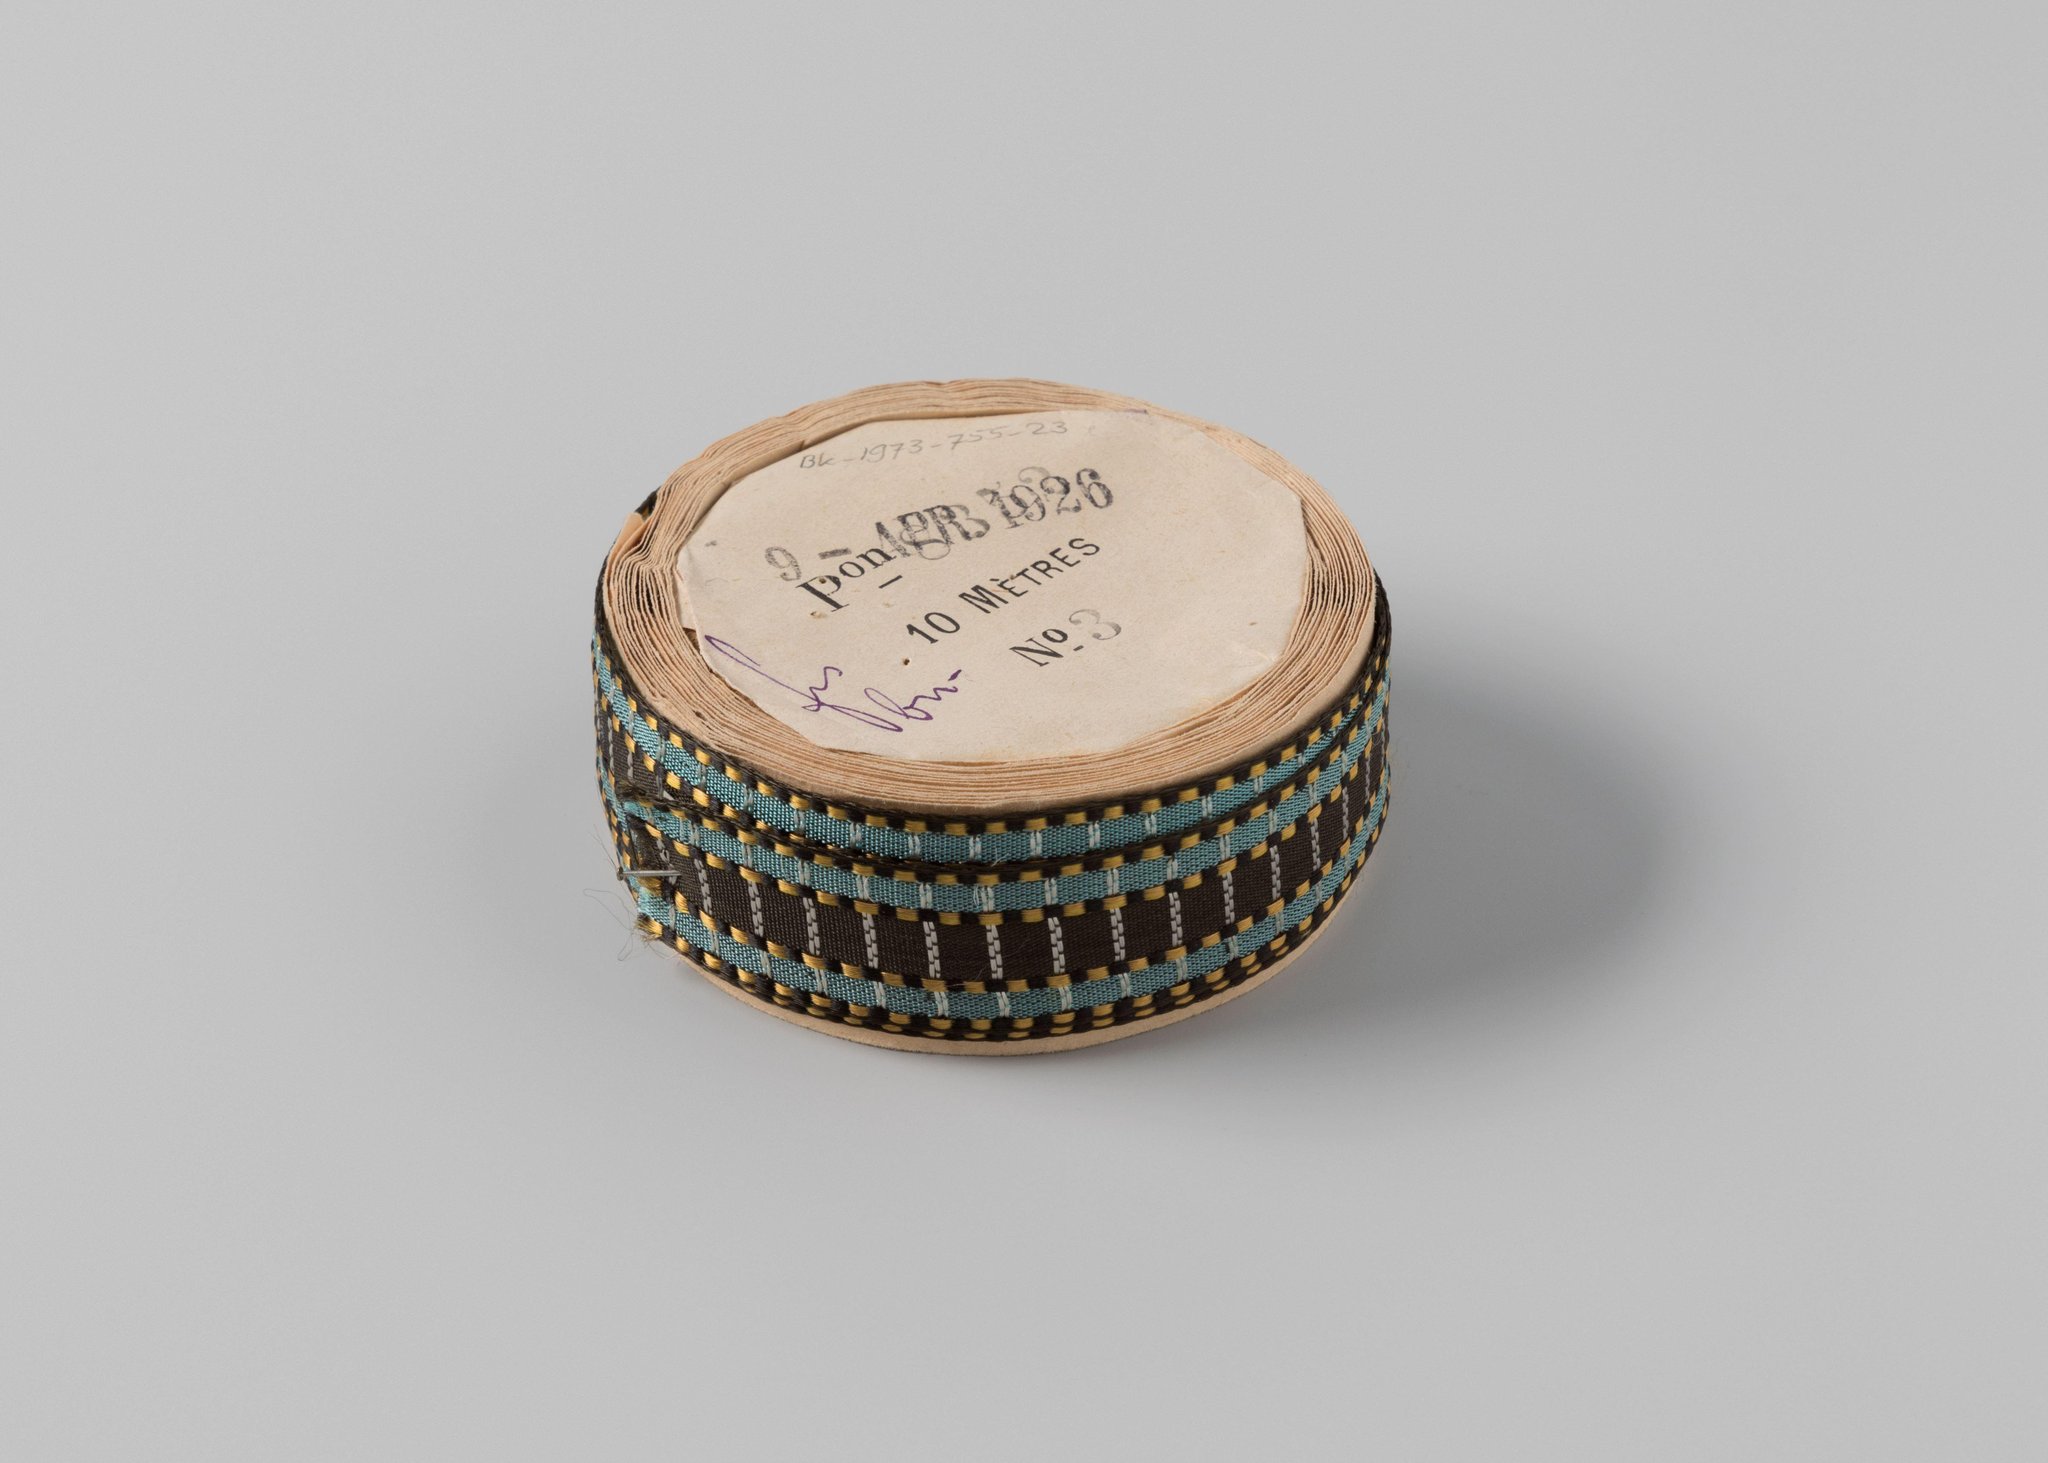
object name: braid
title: Lint op rol, in het midden een zwarte streep met aan weerszijden een blauwe streep die aan beide kanten is omzoomd met een afwisselend gele en zwarte streep, overdwars een witte streep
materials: cardboard, paper, textile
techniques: embroidered, weave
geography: nijmegen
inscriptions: number: ‘Pon 8352’, stamp: ‘9 - APR. 1926’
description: Lint op rol, in het midden een zwarte streep met aan weerszijden een blauwe streep die aan beide kanten is omzoomd met een afwisselend gele en zwarte streep, overdwars een witte streep.